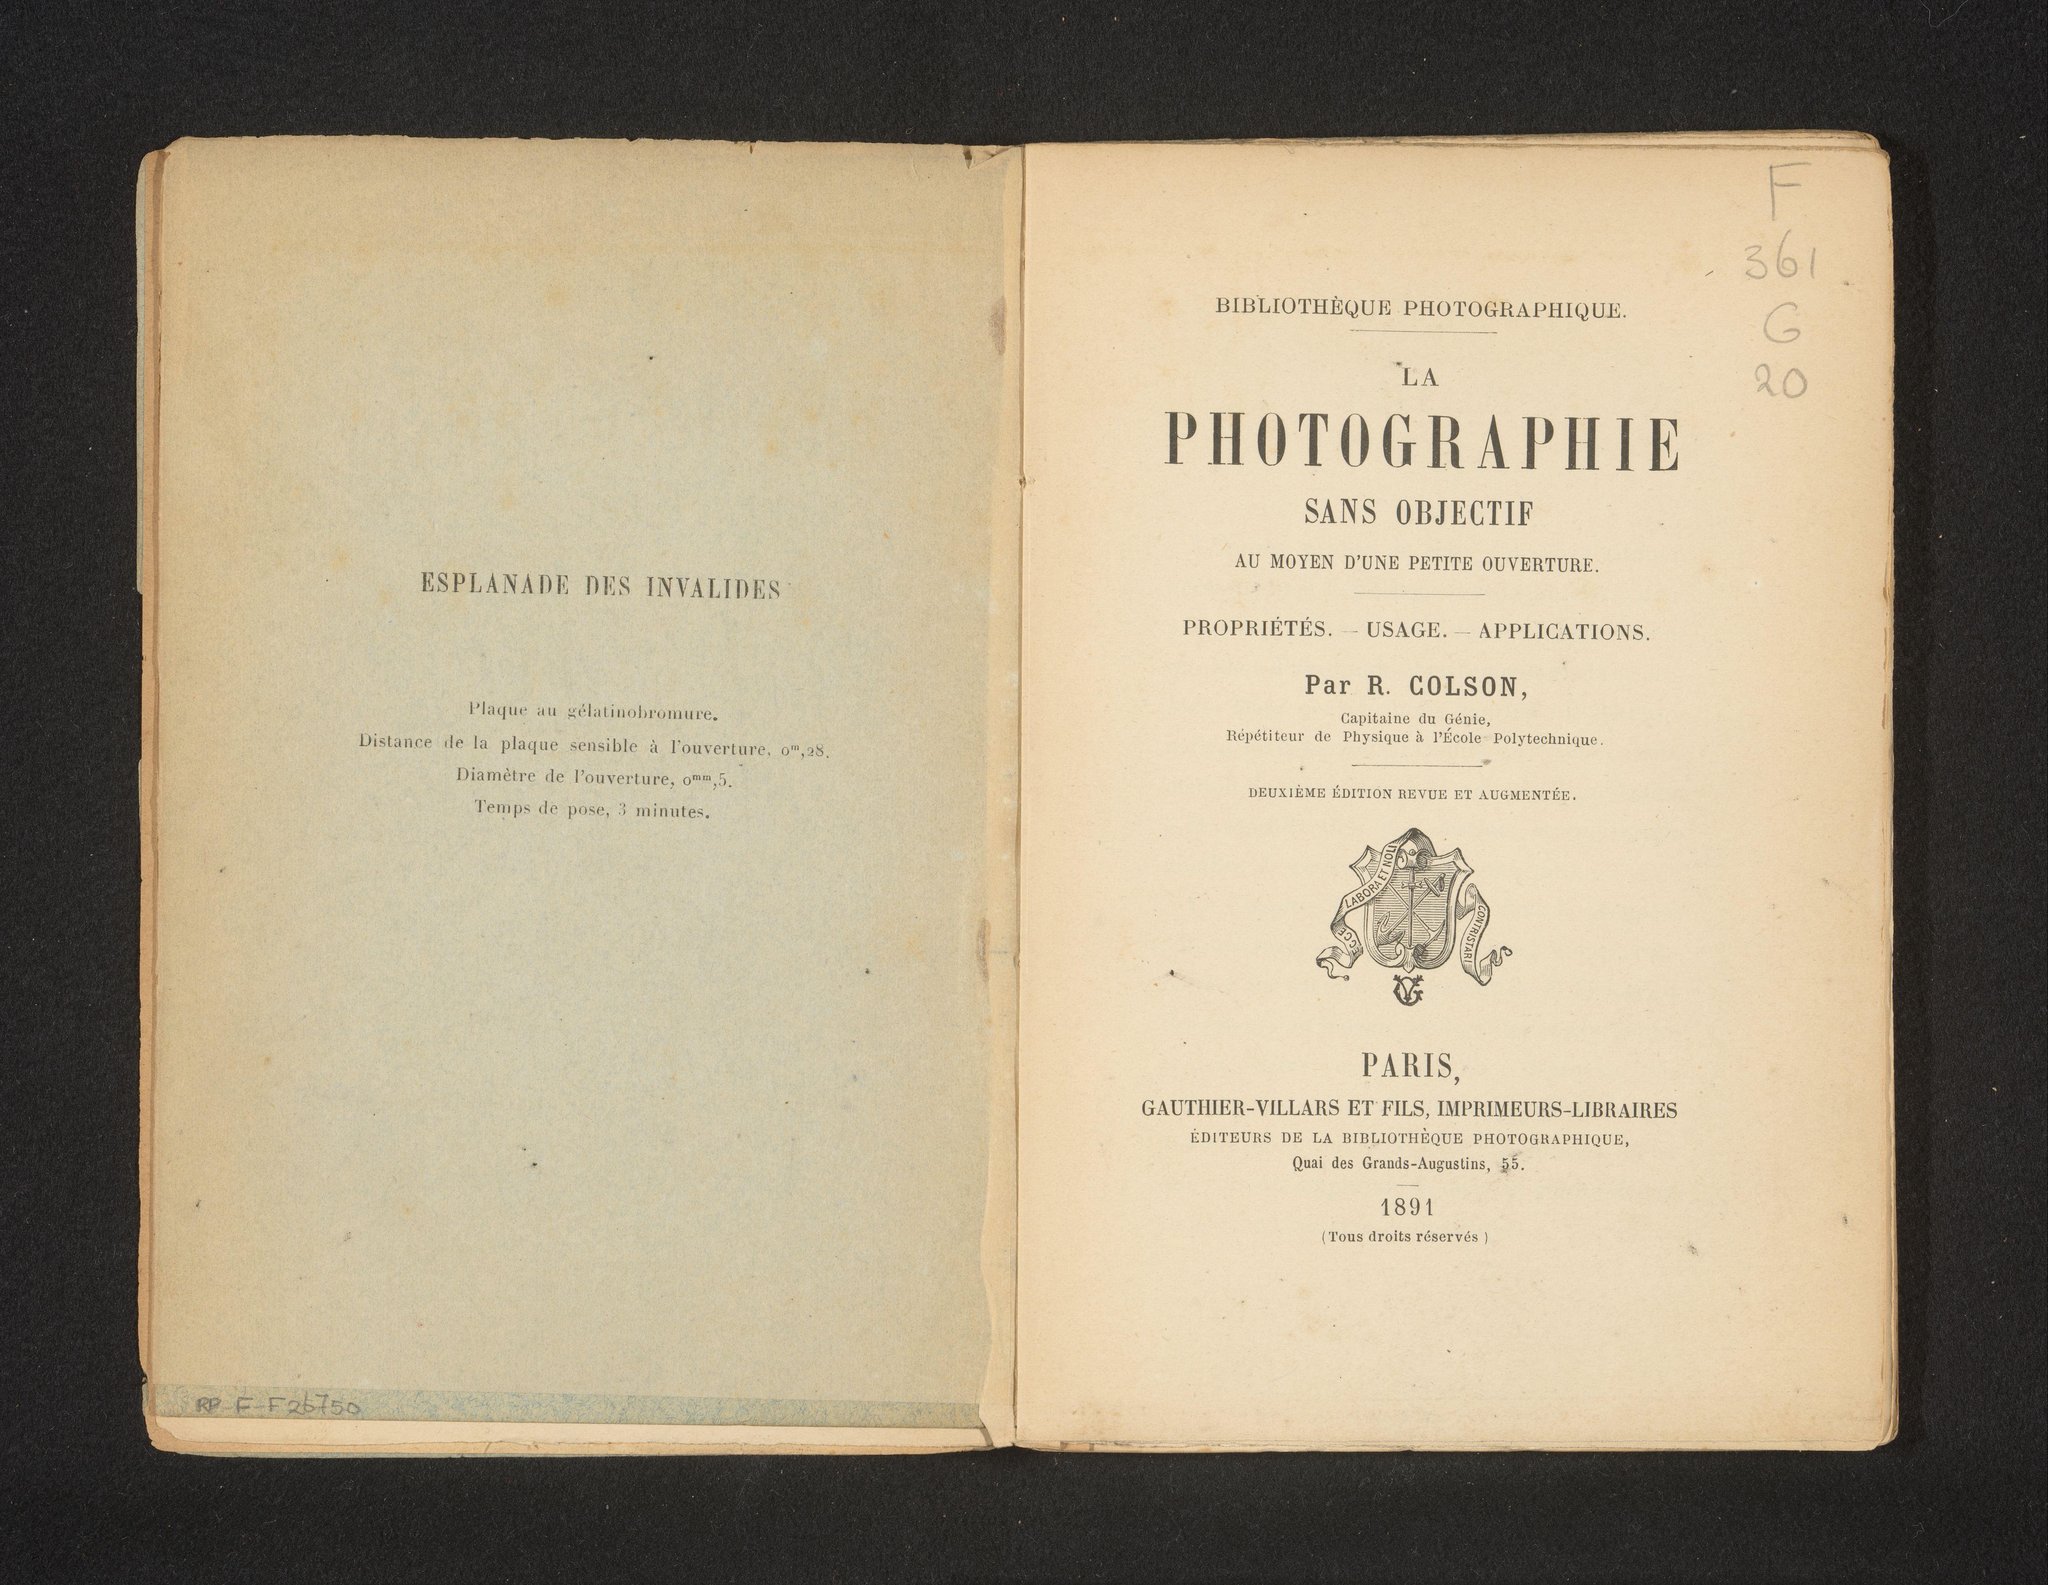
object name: book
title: La photographie sans objectif au moyen d'une petite ouverture : propiétés, usage, applications / par R. Colson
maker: rené colson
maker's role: fotograaf, militair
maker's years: 1853-1941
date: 1891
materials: cardboard, paper, photographic support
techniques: albumen print, printing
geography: paris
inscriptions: check stamp: ‘HOMMAGE’